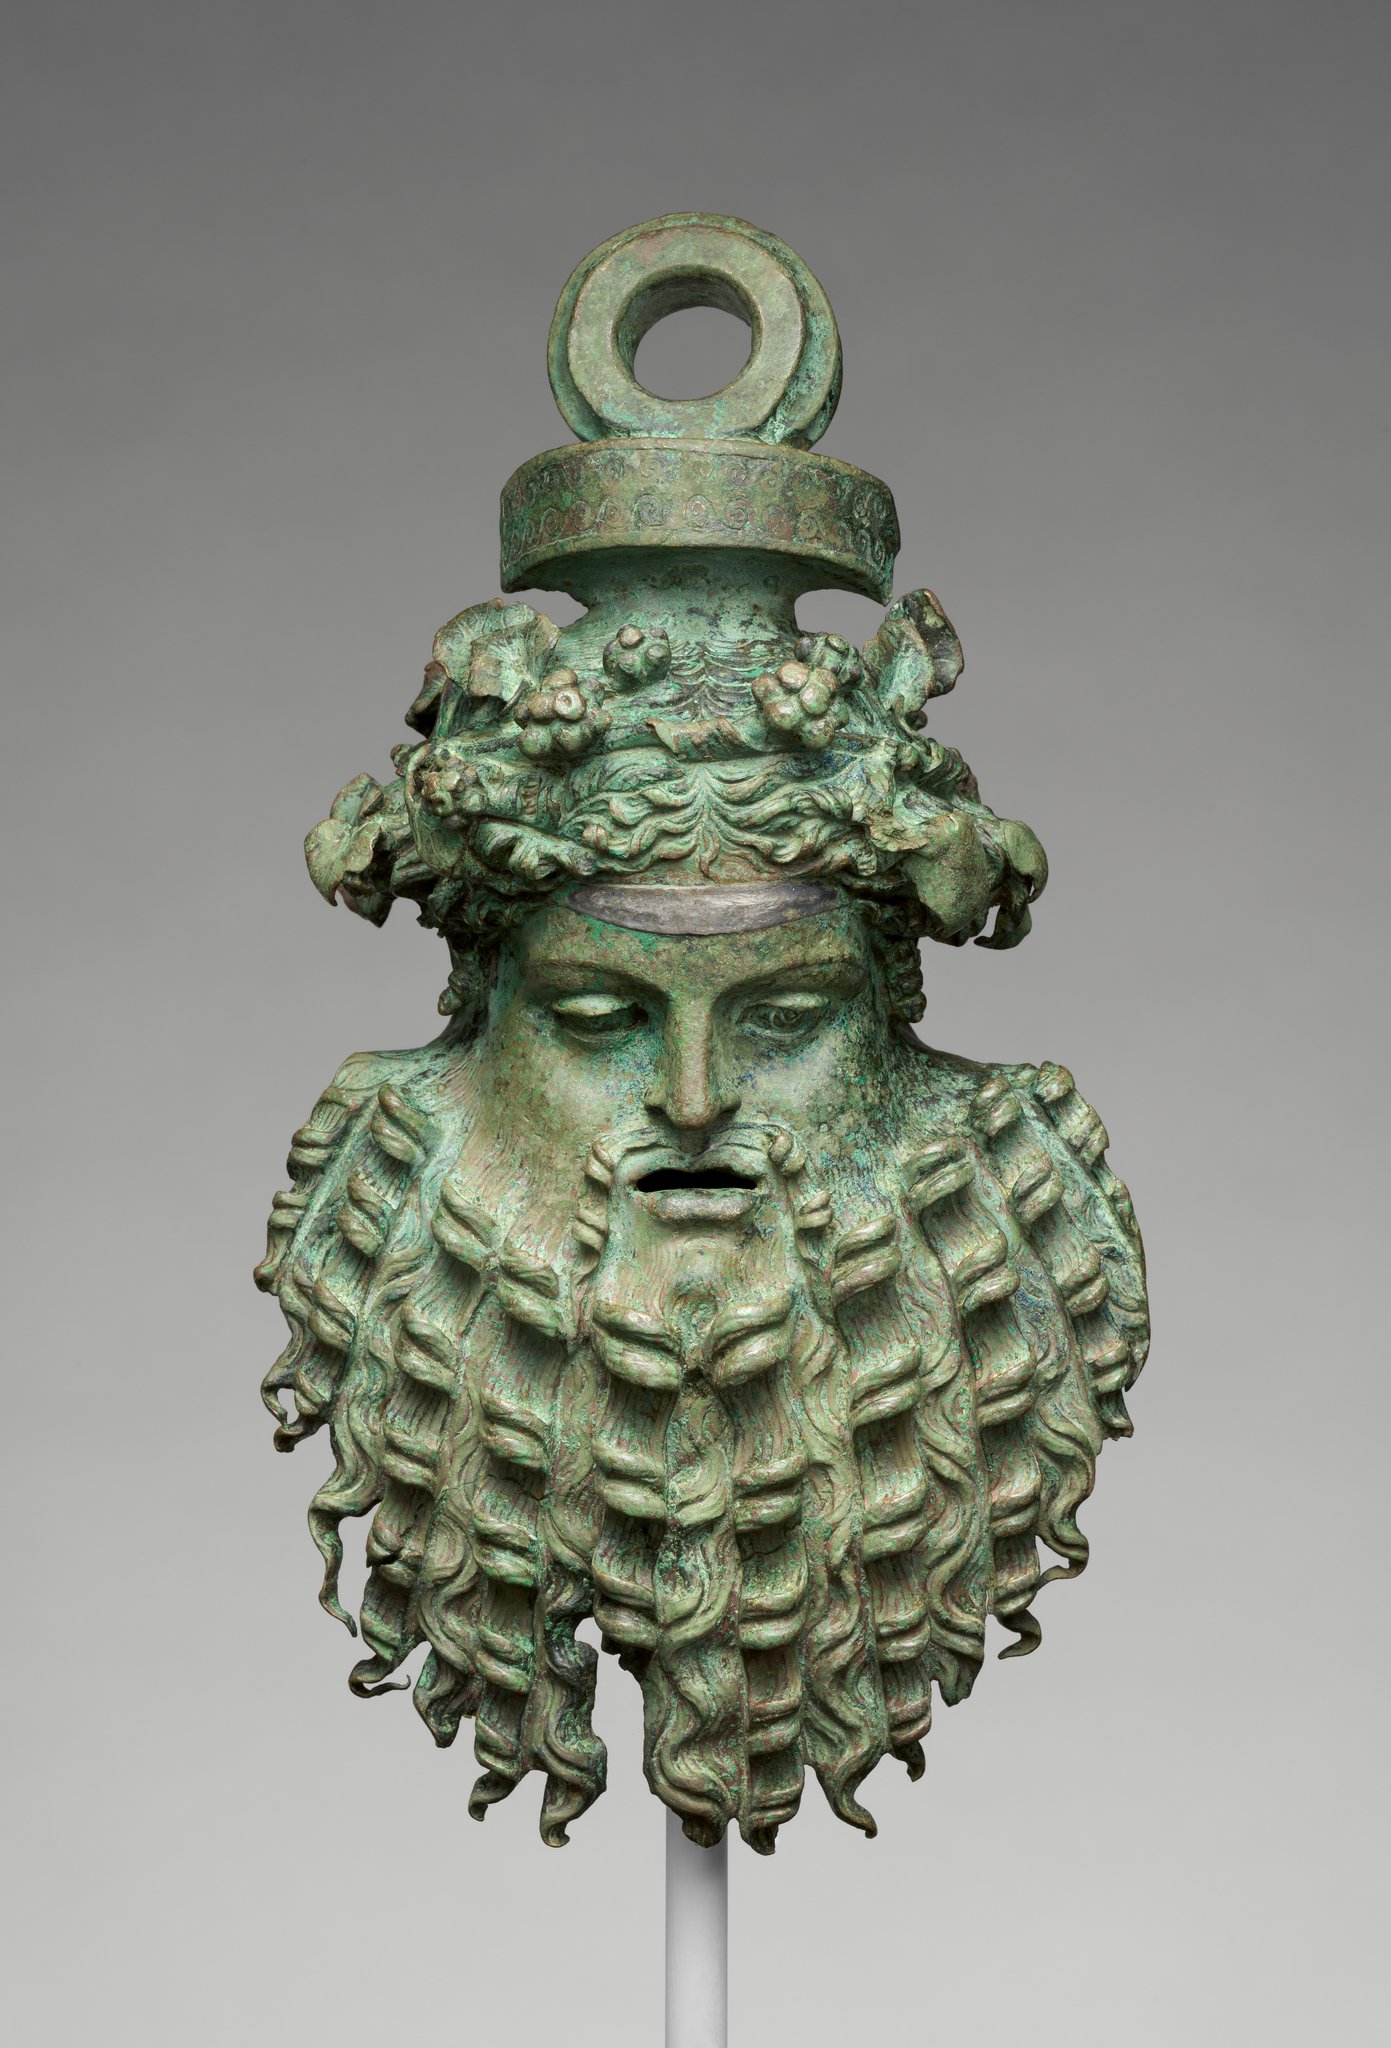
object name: handle of a situla, mask of silenos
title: Bronze handle attachment in the form of a mask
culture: greek or roman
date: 100 BCE-100 CE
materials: bronze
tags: masks,faces